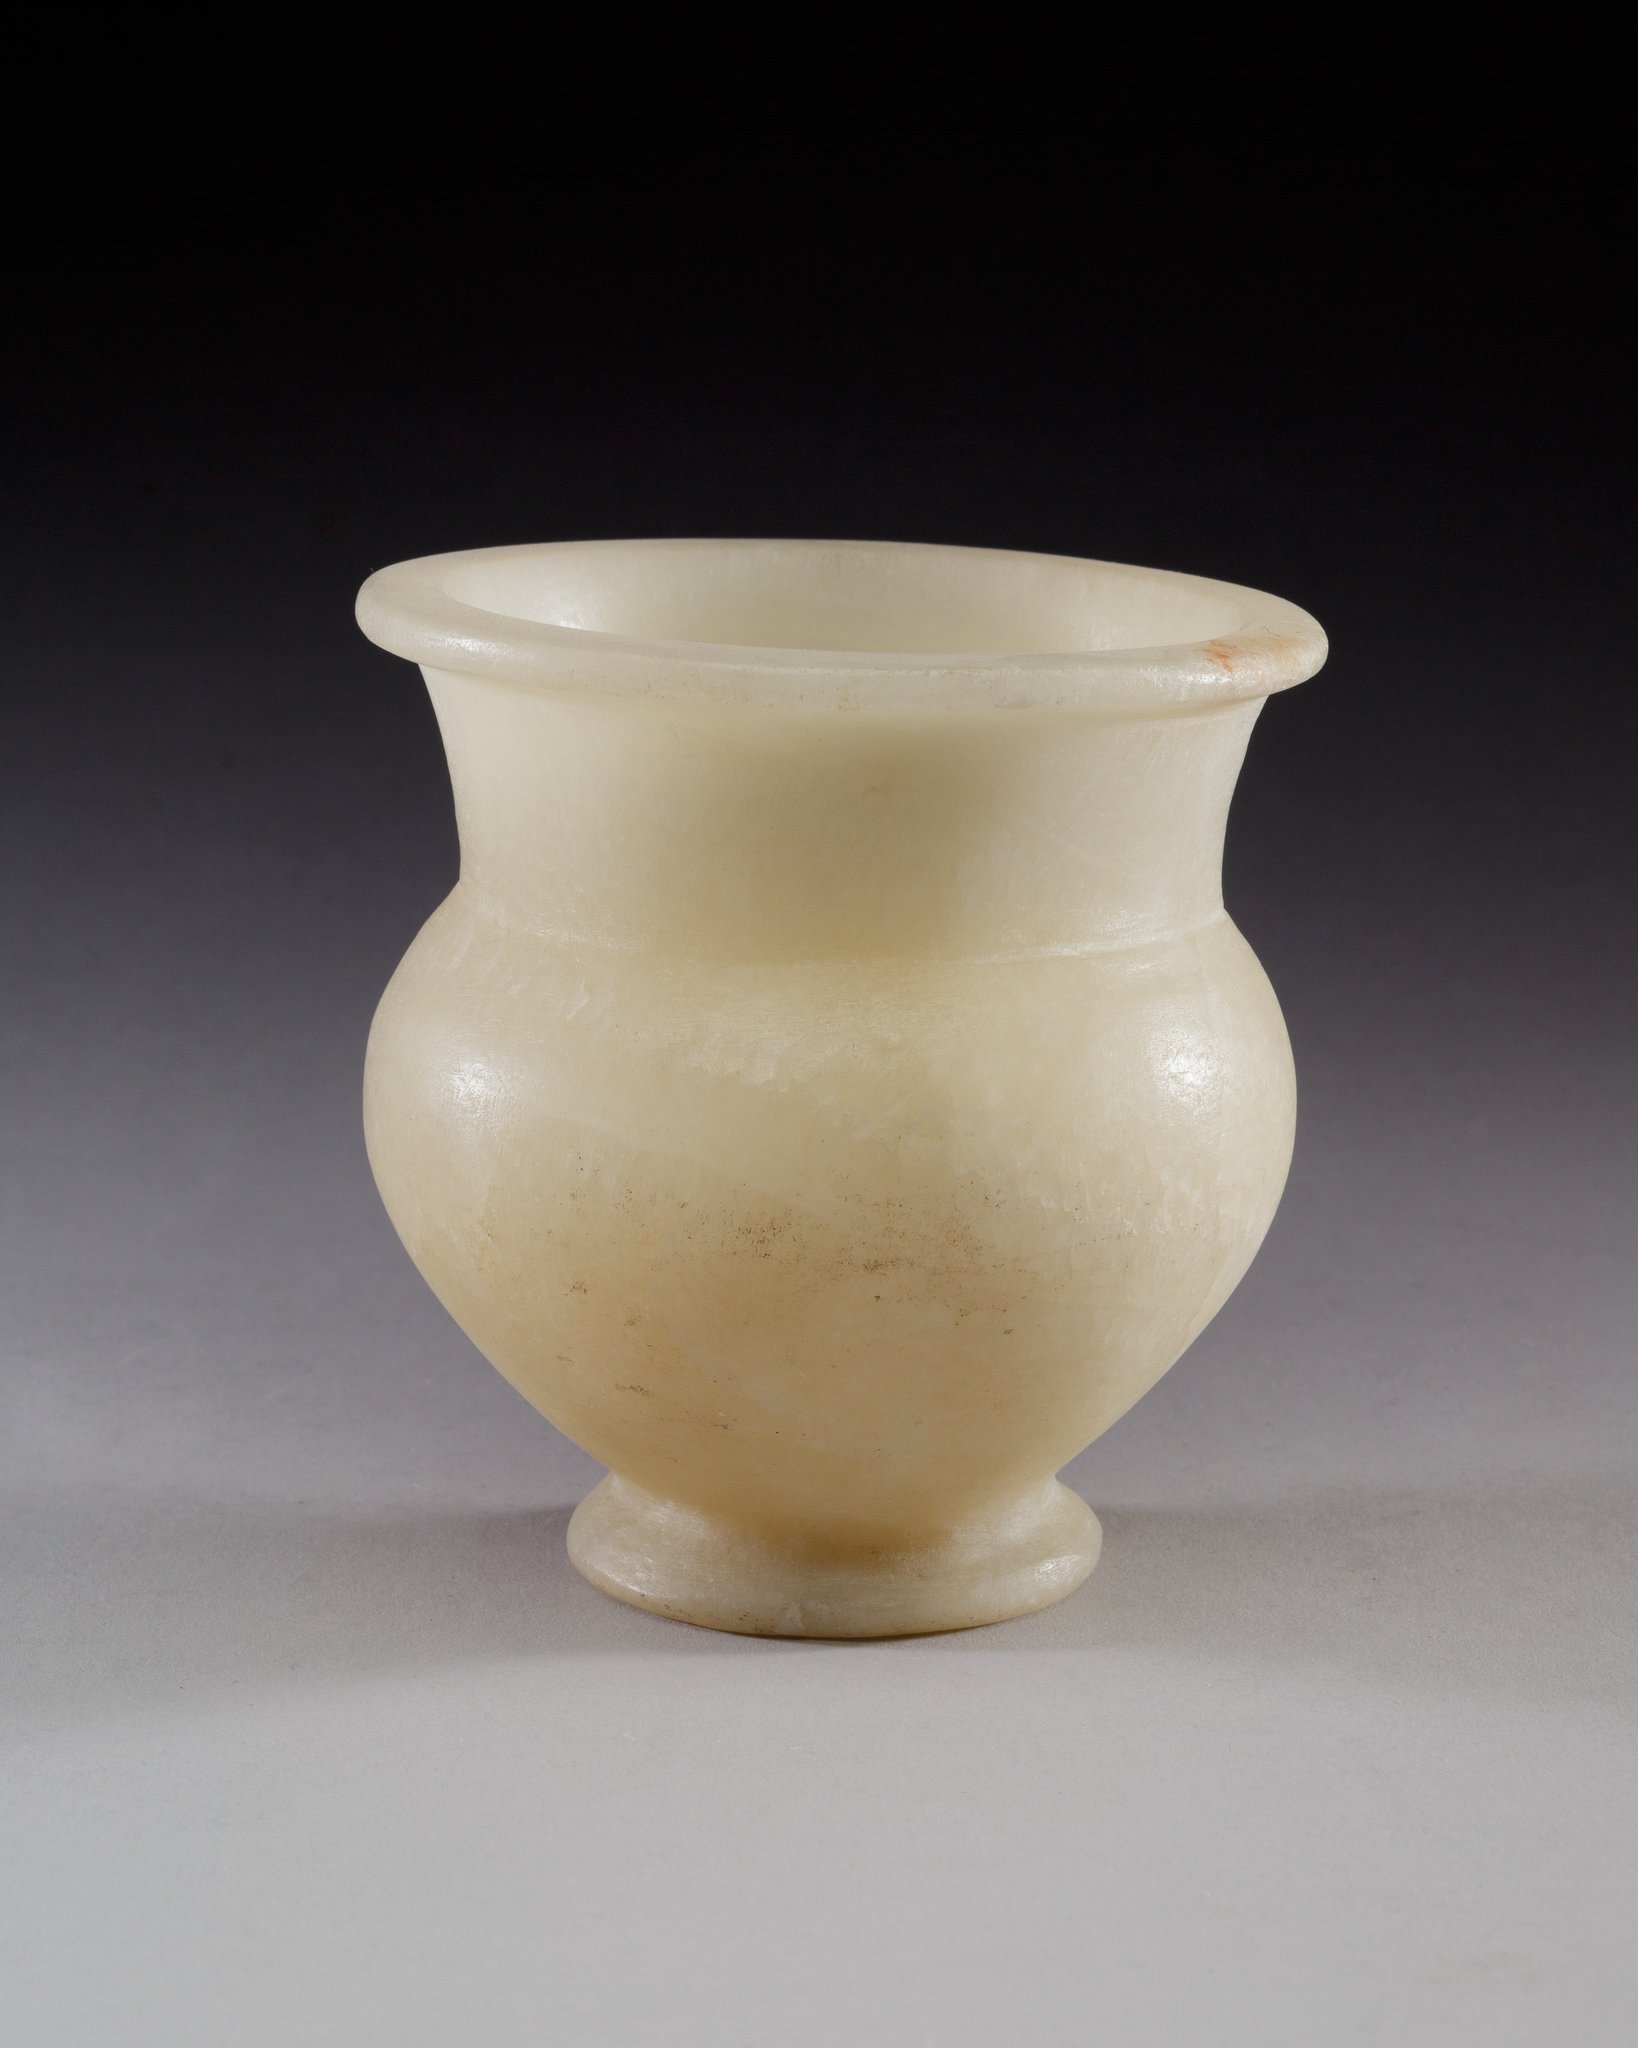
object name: jar, open mouthed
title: Jar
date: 1492-1473 BCE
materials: stone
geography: egypt